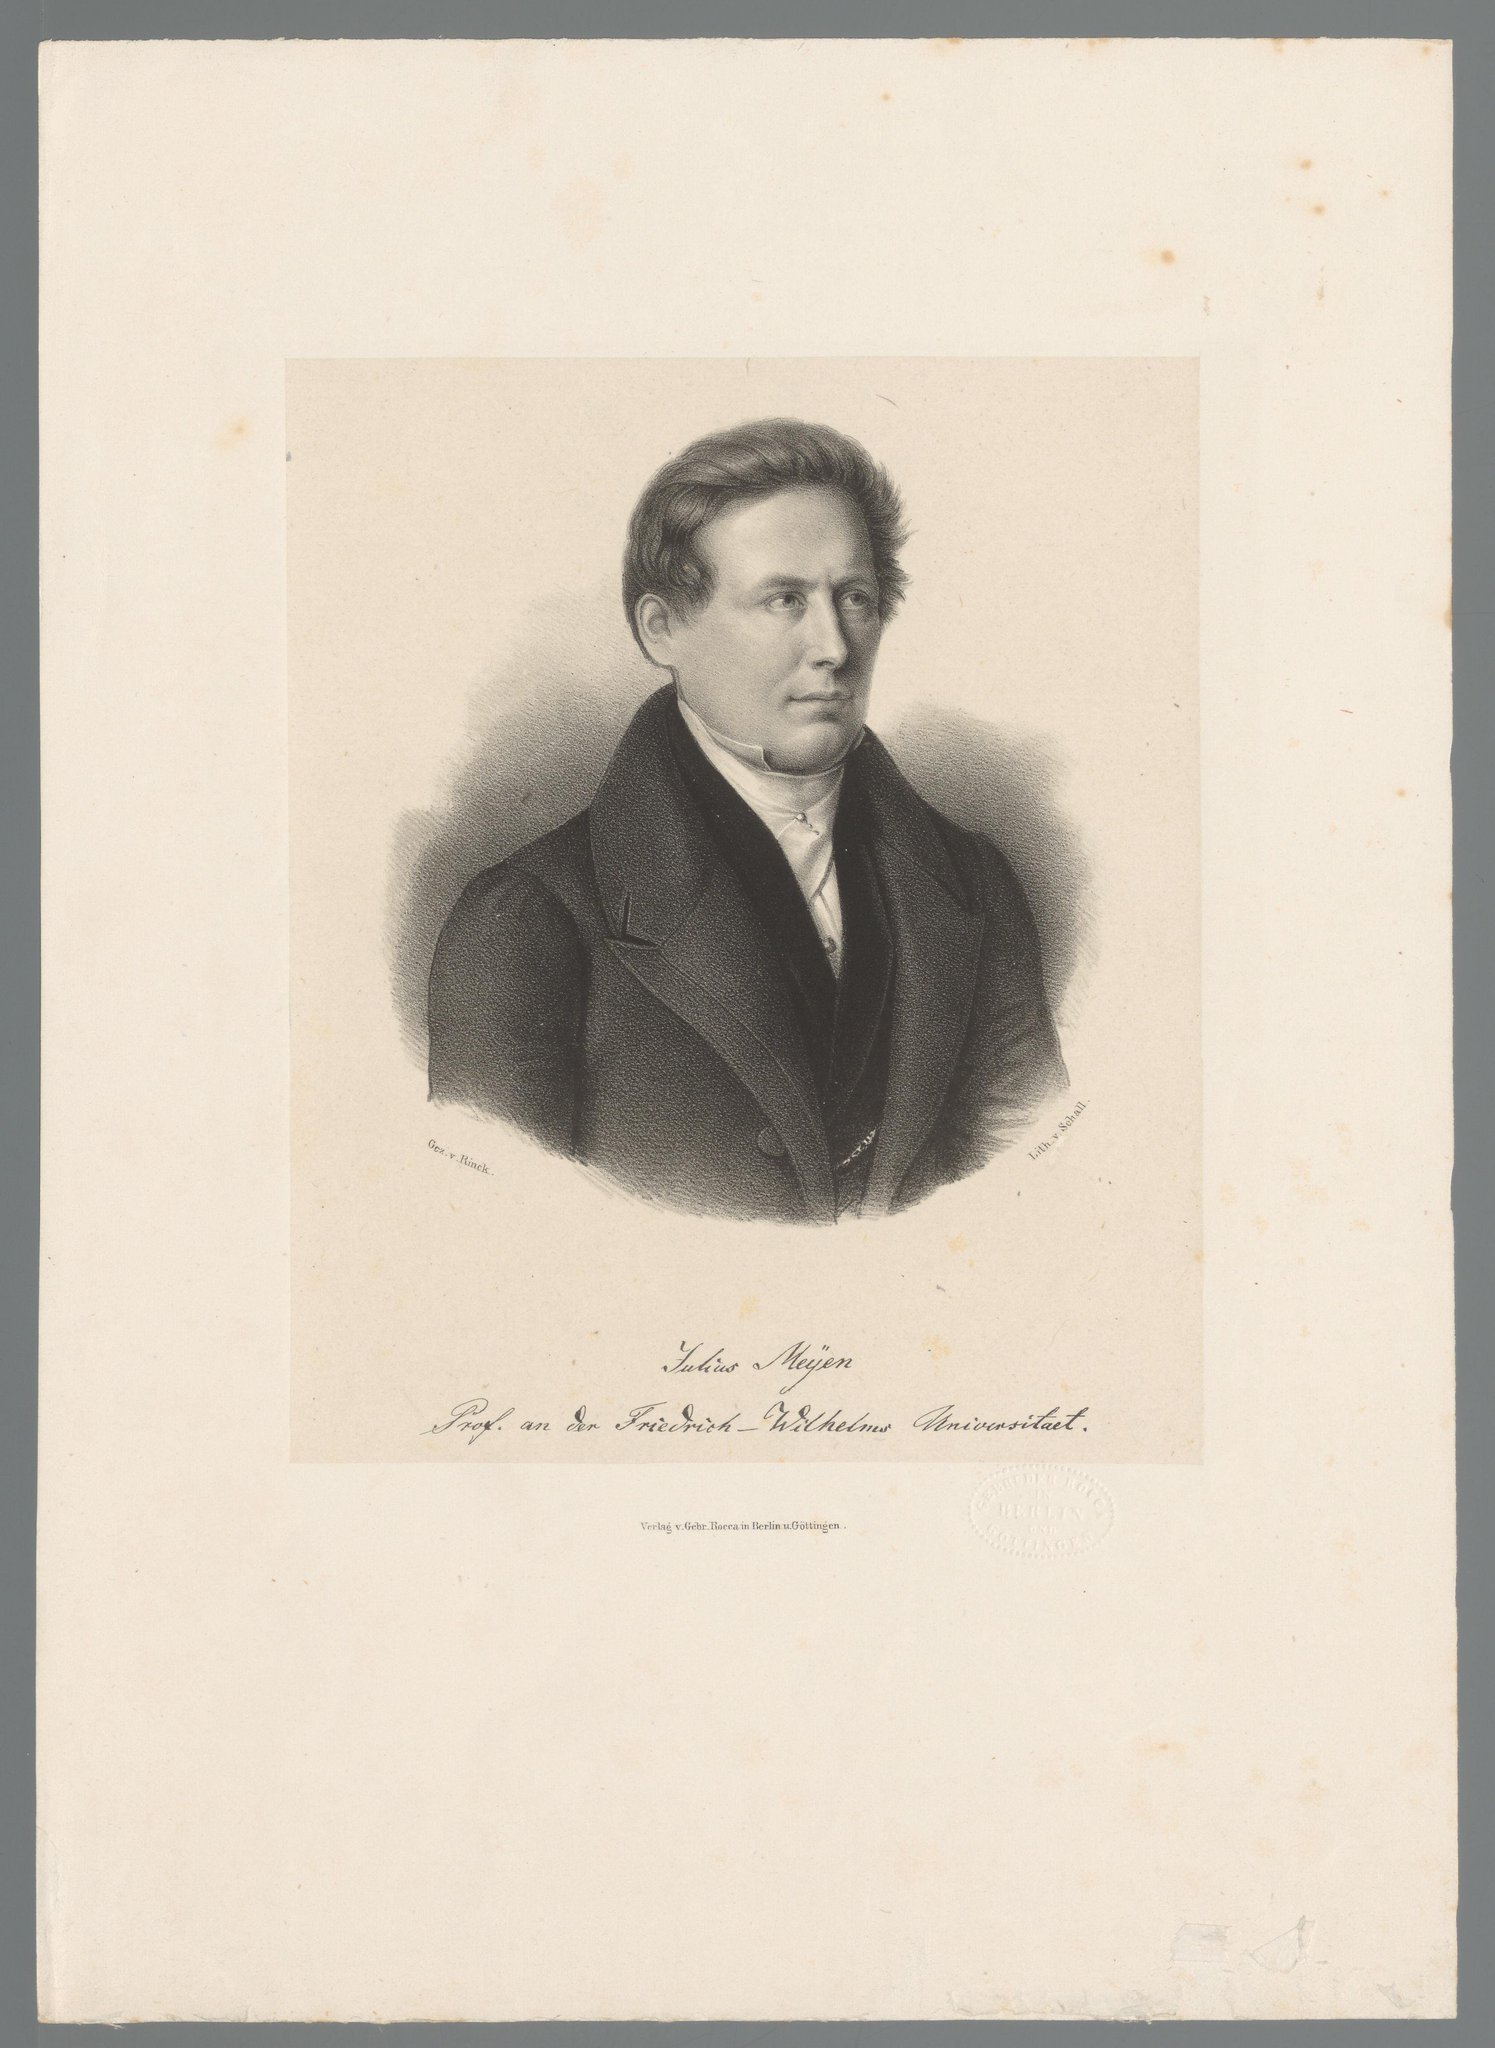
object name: print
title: Portret van Franz Julius Ferdinand Meyen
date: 1820-1865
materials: paper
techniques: lithograph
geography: gottingen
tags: adult man, historical persons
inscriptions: collector's mark: Lugt 2228, check stamp: Lugt 5514